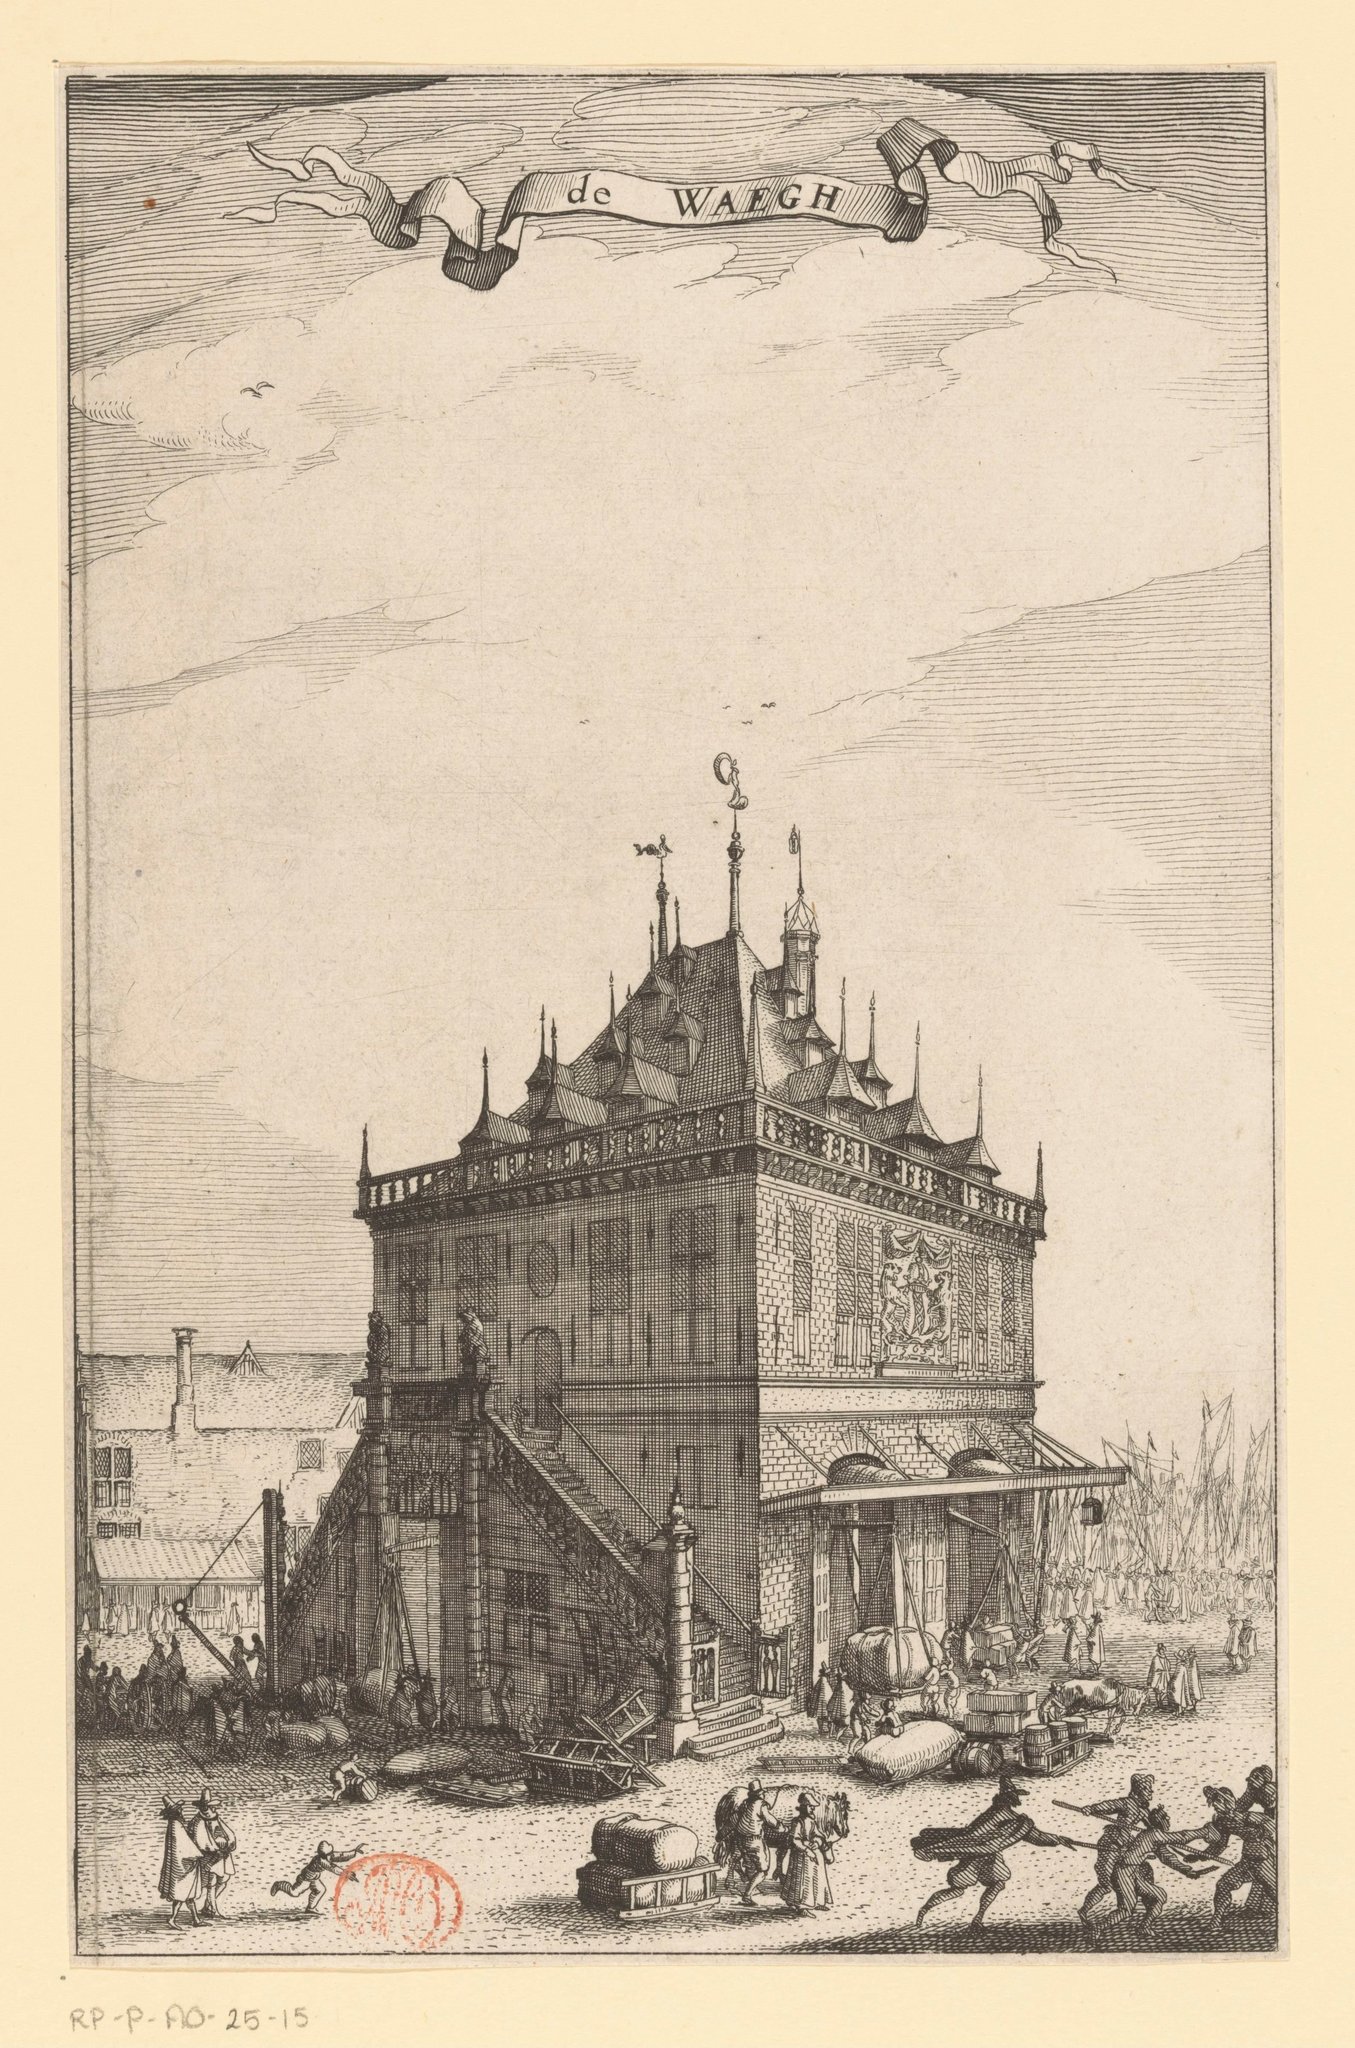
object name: book illustration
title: de Waegh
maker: claes jansz. visscher (ii)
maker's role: draughtsman, print maker, publisher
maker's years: 1586-1652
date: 1601-1612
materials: paper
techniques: engraving, etching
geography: amsterdam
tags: sleigh, sledge (non-sport), weigh-house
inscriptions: collector's mark: Lugt 195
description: Oorspronkelijk van één plaat gedrukt met een voorstelling van het Oude Stadhuis op de Dam (zie RP-P-AO-21-2 en RP-P-1884-A-7655). Prent in zijn geheel komt ook voor in enkele exemplaren van: Guicciardini, Lodovico. Beschryvinghe van alle de Neder-landen, anderssins ghenoemt Neder-Duytslandt (…). Amsterdam: Willem Janszoon Blaeu, 1612. En in enkele exemplaren van latere uitgaven van deze publicatie, uitgegeven door Blaeu (1613) en Johannes Janssonius (1624, 1625, 1646 en 1648). Zie ook RP-P-AO-23-1 en RP-P-AO-23-13.